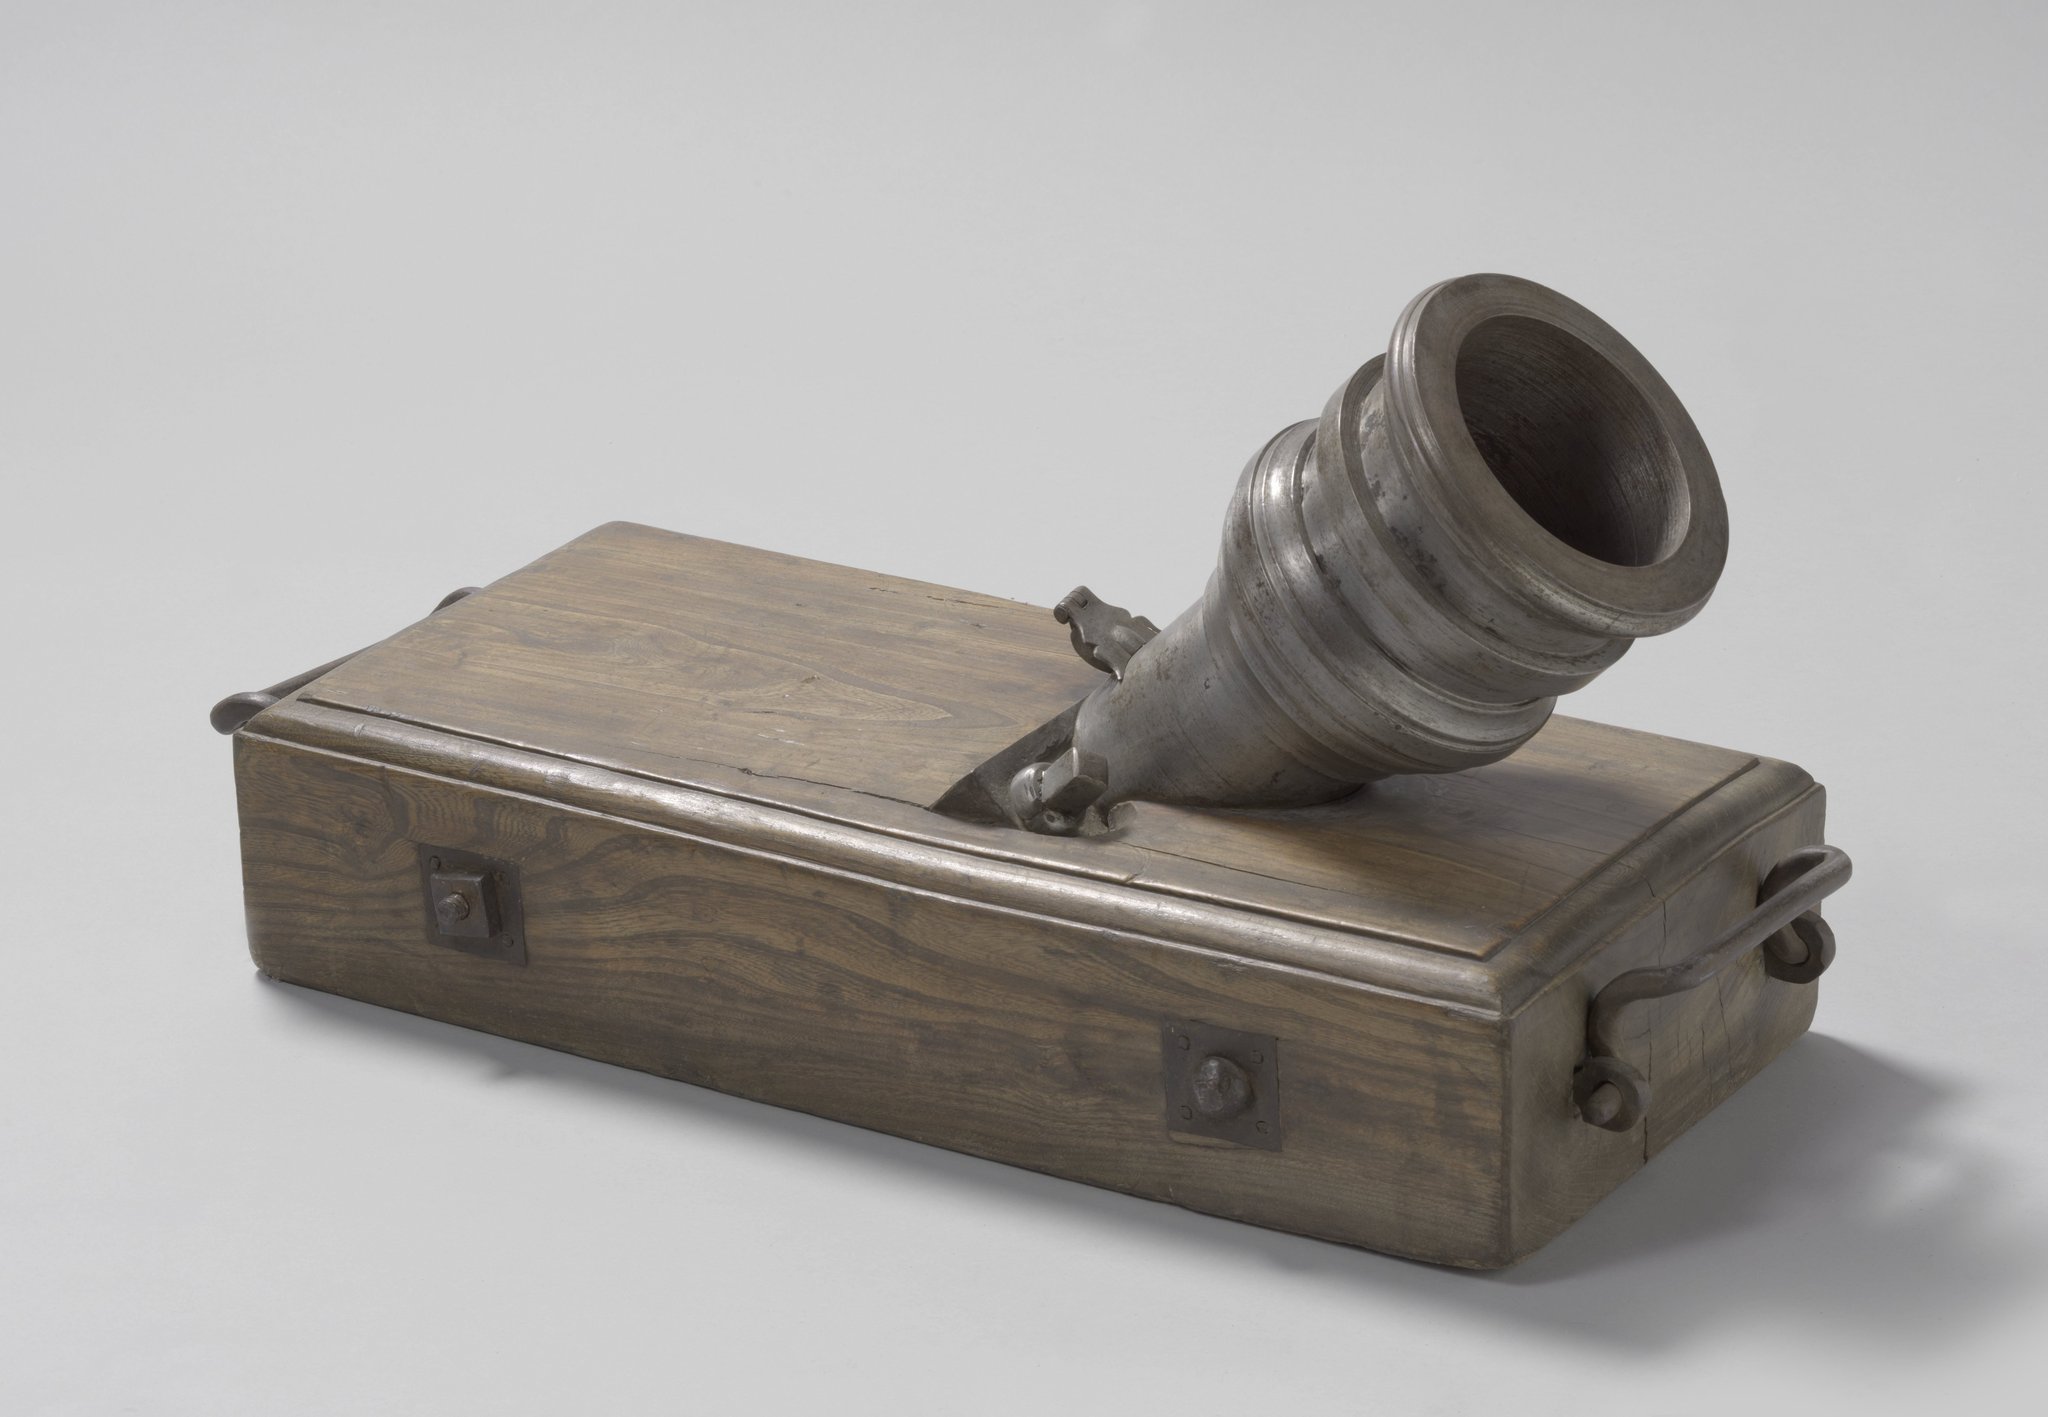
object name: cannon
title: IJzeren mortier op houten onderstel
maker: Anonymous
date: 1700-1800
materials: wood, iron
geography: netherlands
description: IJzeren mortier op iepenhouten onderstel. Onderstel vernieuwd.